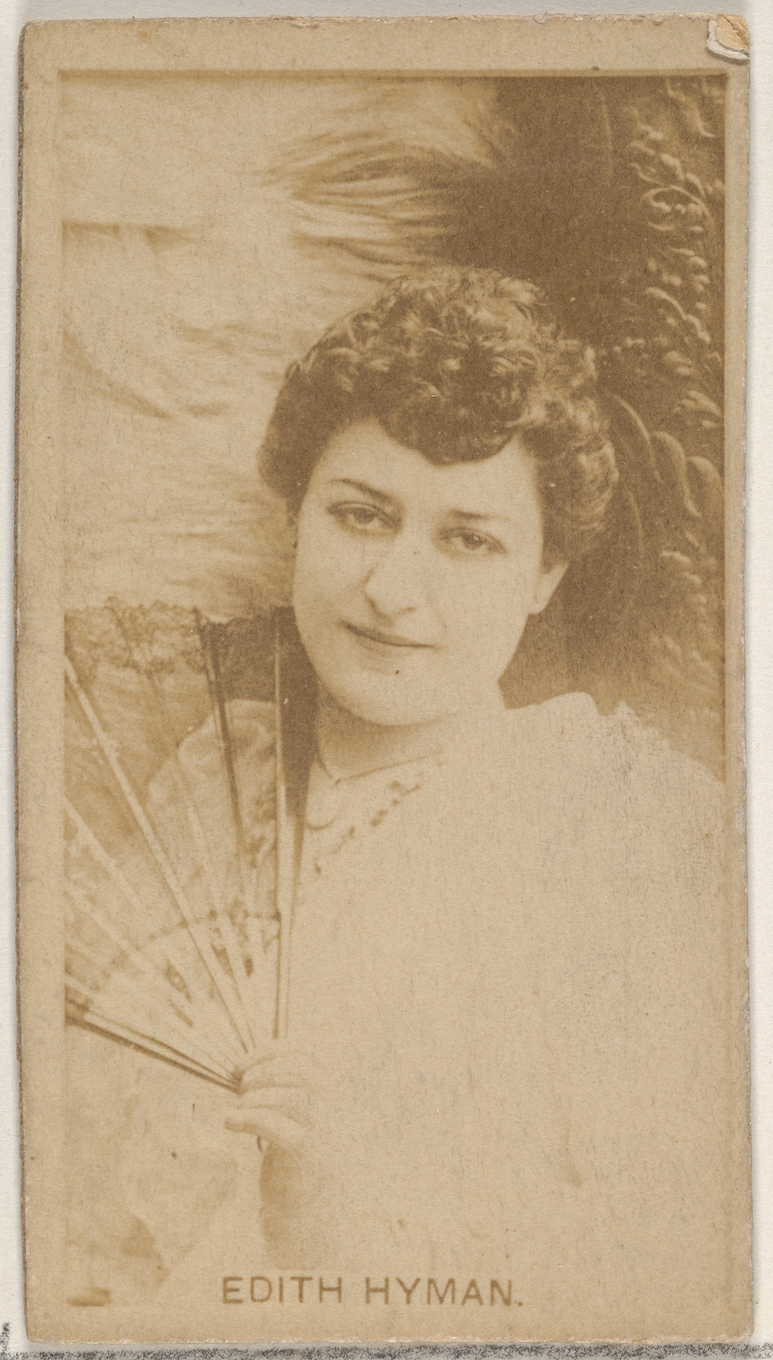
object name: photograph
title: Edith Hyman, from the Actors and Actresses series (N45, Type 8) for Virginia Brights Cigarettes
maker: allen & ginter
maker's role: publisher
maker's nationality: american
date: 1888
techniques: albumen silver print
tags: portraits,women,actresses